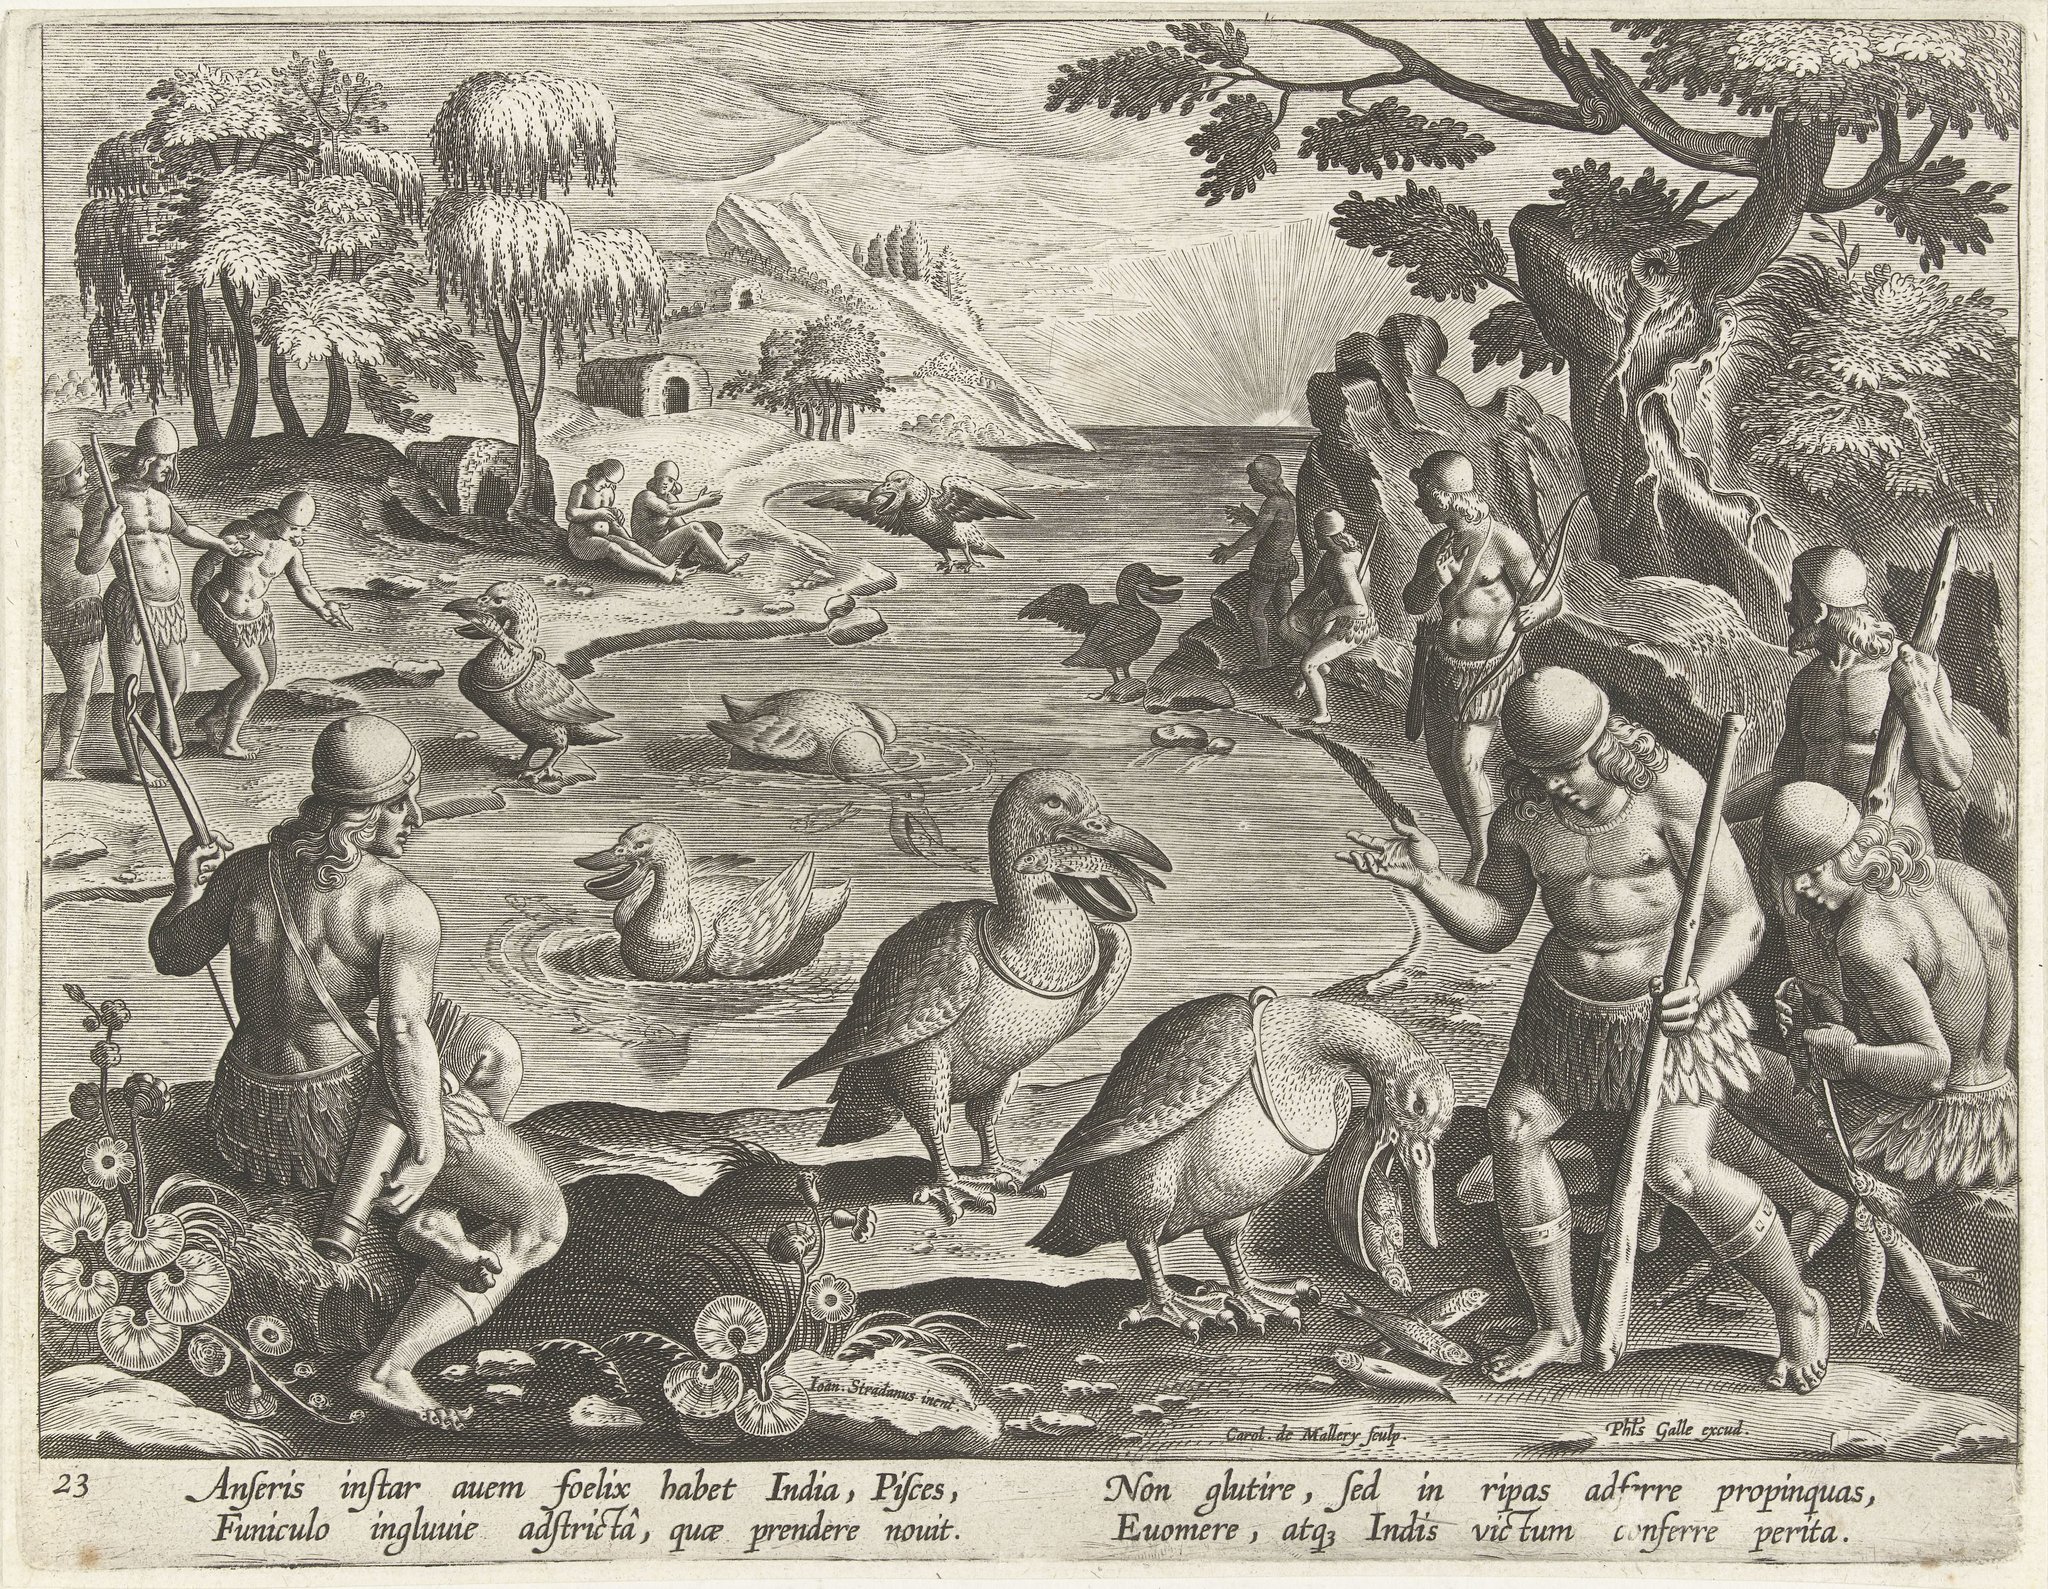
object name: print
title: Native Americans Catching Fish with the Help of Pelicans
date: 1594-1598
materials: paper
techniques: engraving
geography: antwerp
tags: sports, games ~ animals (+ hunting with birds), native peoples of the americas, water-birds: pelican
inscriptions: collector's mark: Lugt 240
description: Oorspronkelijke bewoners van Amerika, gekleed in veren rokken, gewapend met pijl-en-boog en stok, zijn verzameld langs een rivieroever. In de rivier zwemmen pelikanen die vissen vangen en deze naar de kant brengen. Zonsondergang of -opgang aan de horizon. De prent heeft een Latijns onderschrift en is deel van een serie van jachttaferelen.